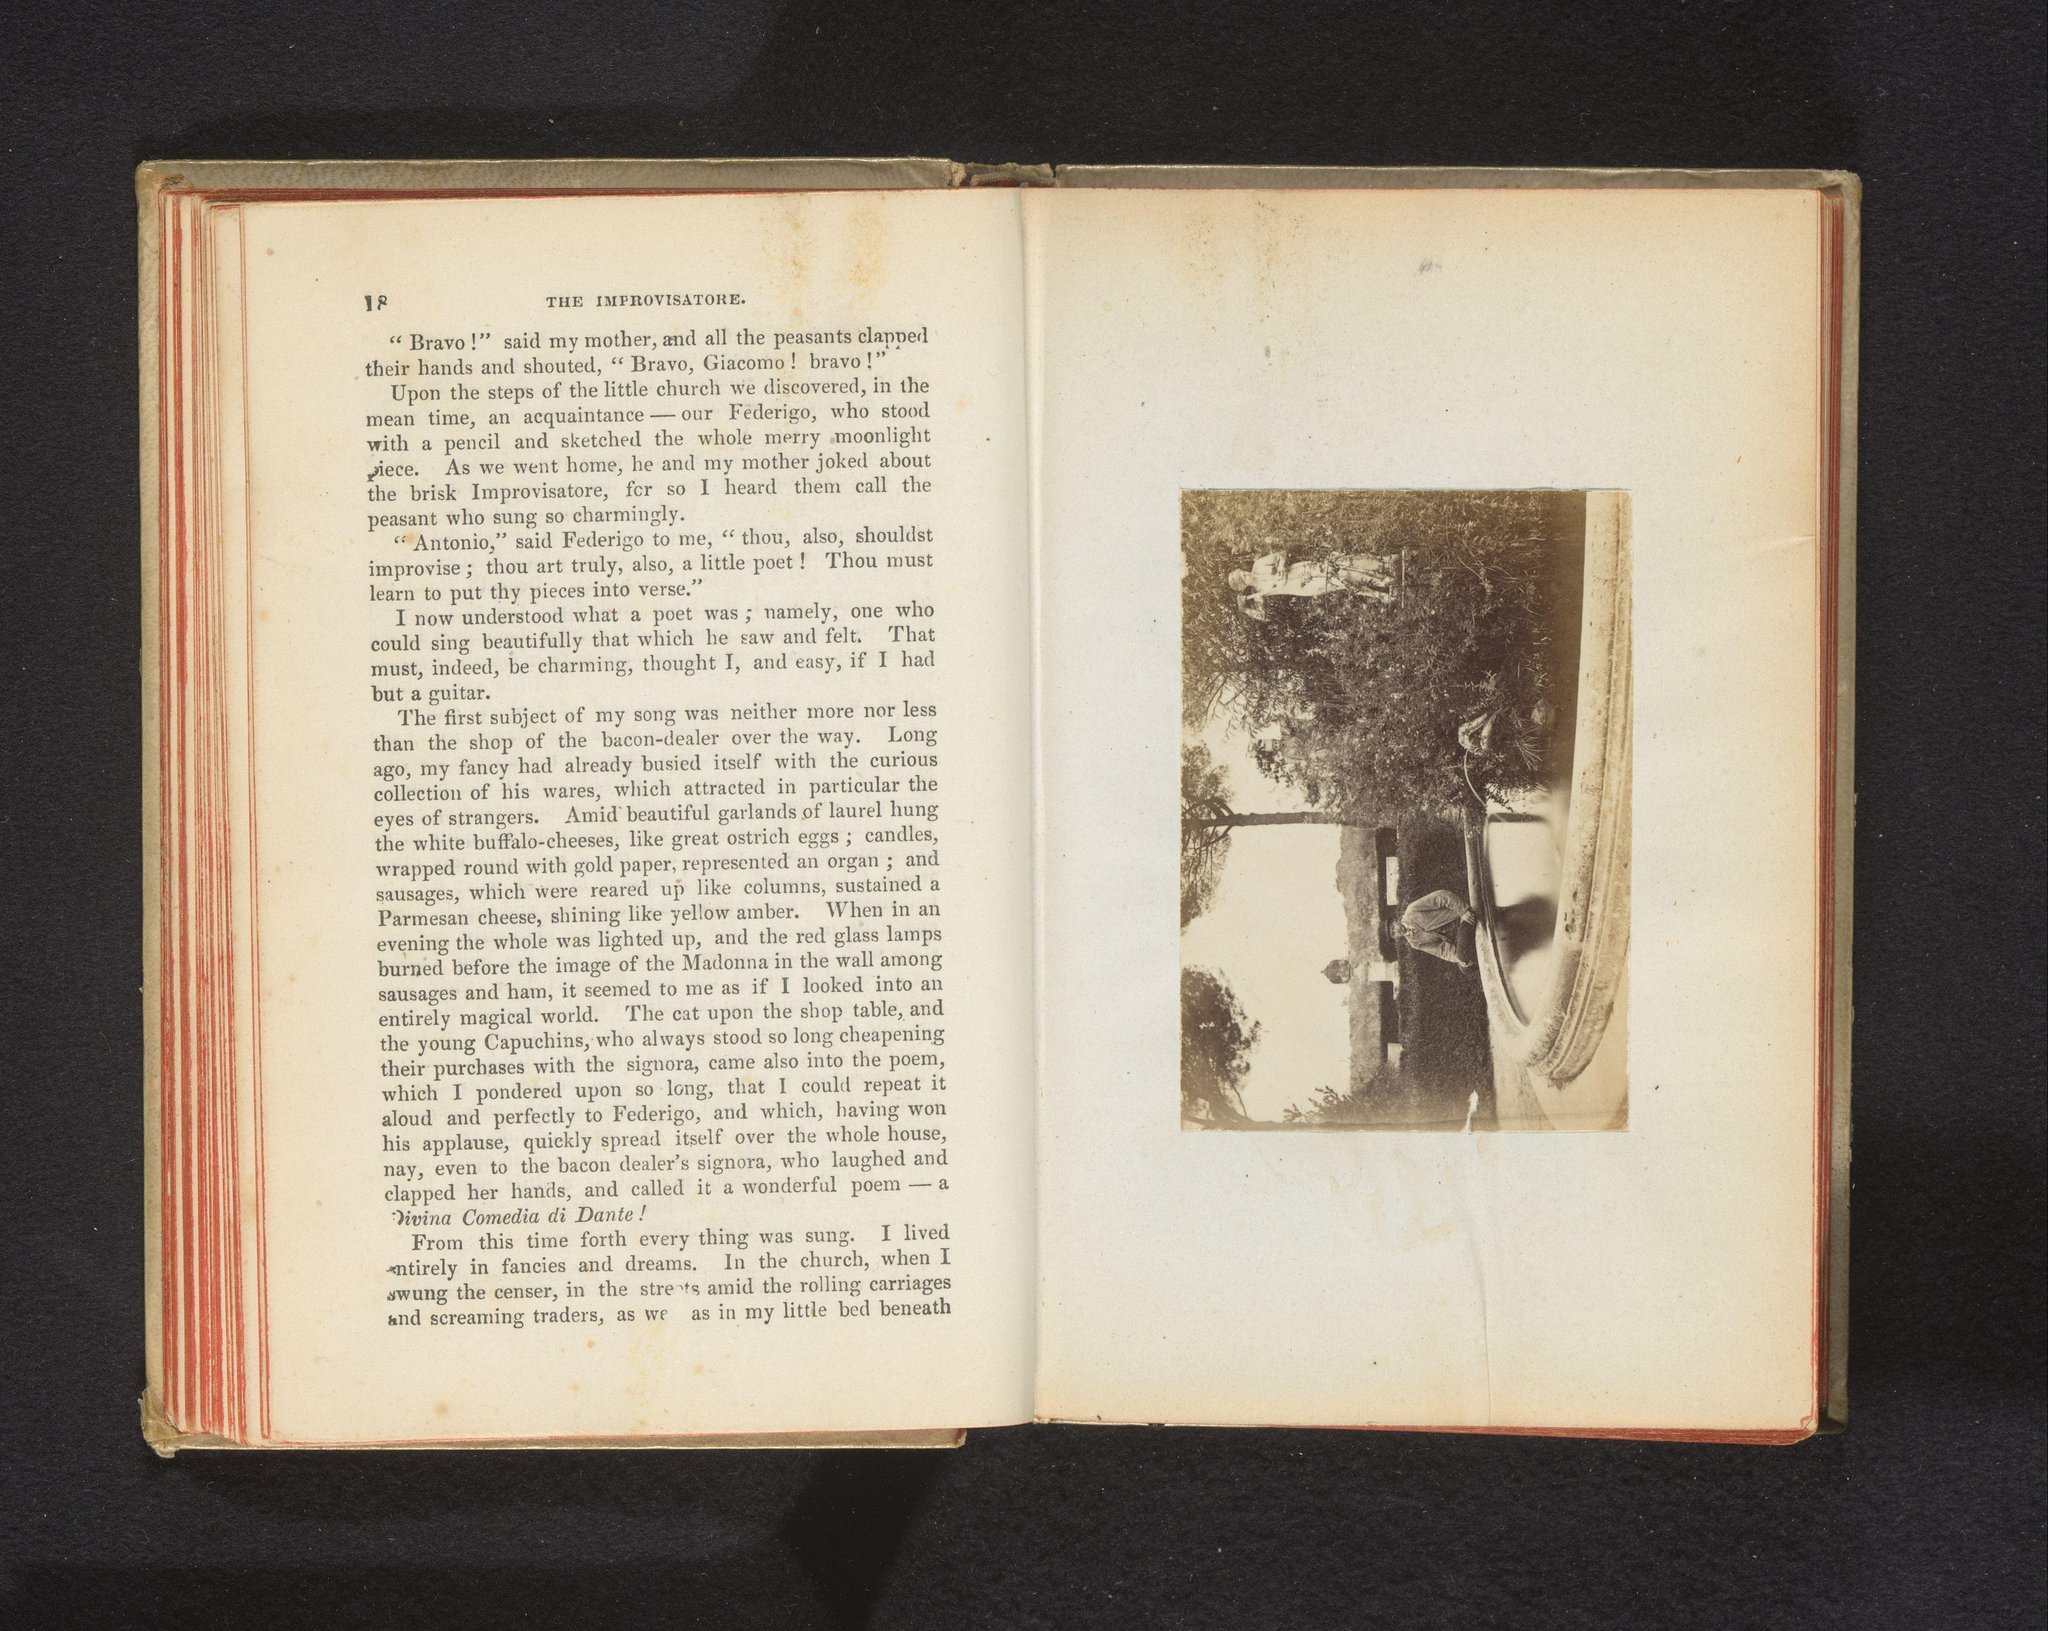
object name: photograph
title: Man langs een waterbassin te Rome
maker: Anonymous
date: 1863-1873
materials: photographic support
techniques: albumen print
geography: rome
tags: adult man, ornamental fountain